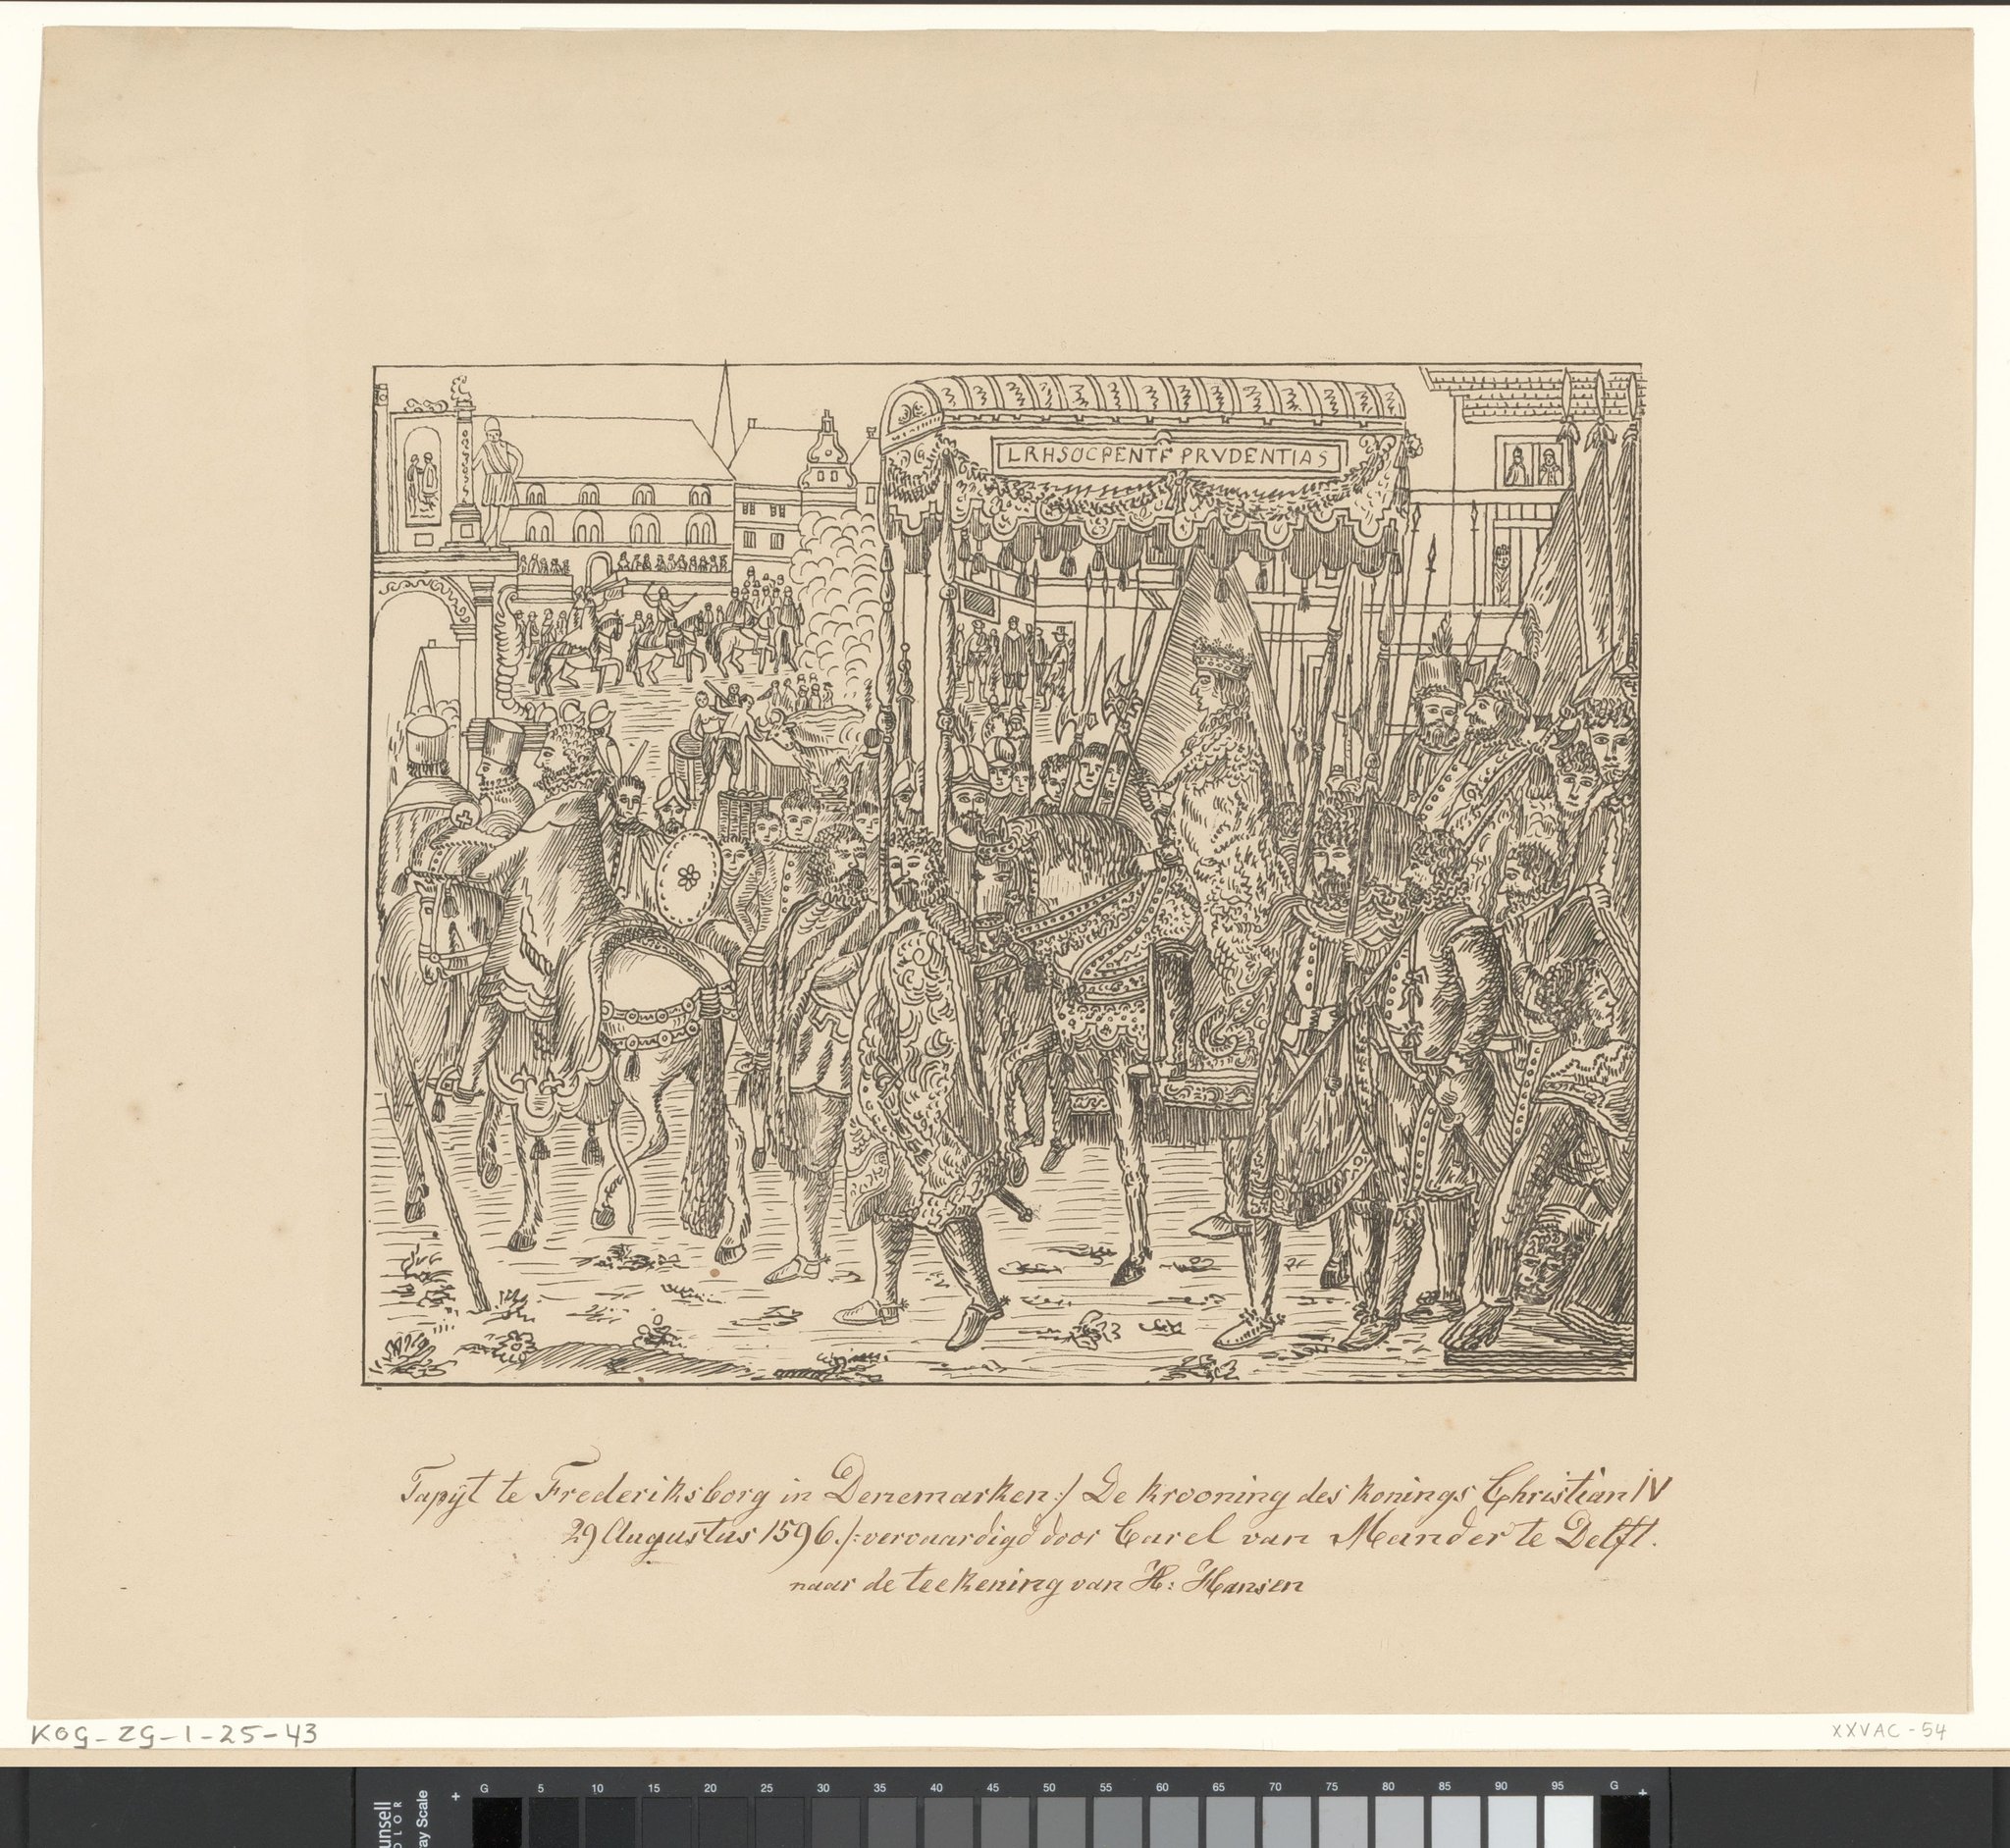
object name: print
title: Kroning van Christiaan IV, koning van Denemarken en Noorwegen, 29 augustus 1596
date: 1870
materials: paper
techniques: lithograph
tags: christiaan iv (koning van denemarken en noorwegen), castle, siege, delft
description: Naar een tapijt uit Frederiksborg. Onderwerpsrubrieken binnen de Atlas Zeden en Gewoonten: Zeden en Gewoonten in Engeren Zin, De Woning, Binnenhuizen, Wandversiering.